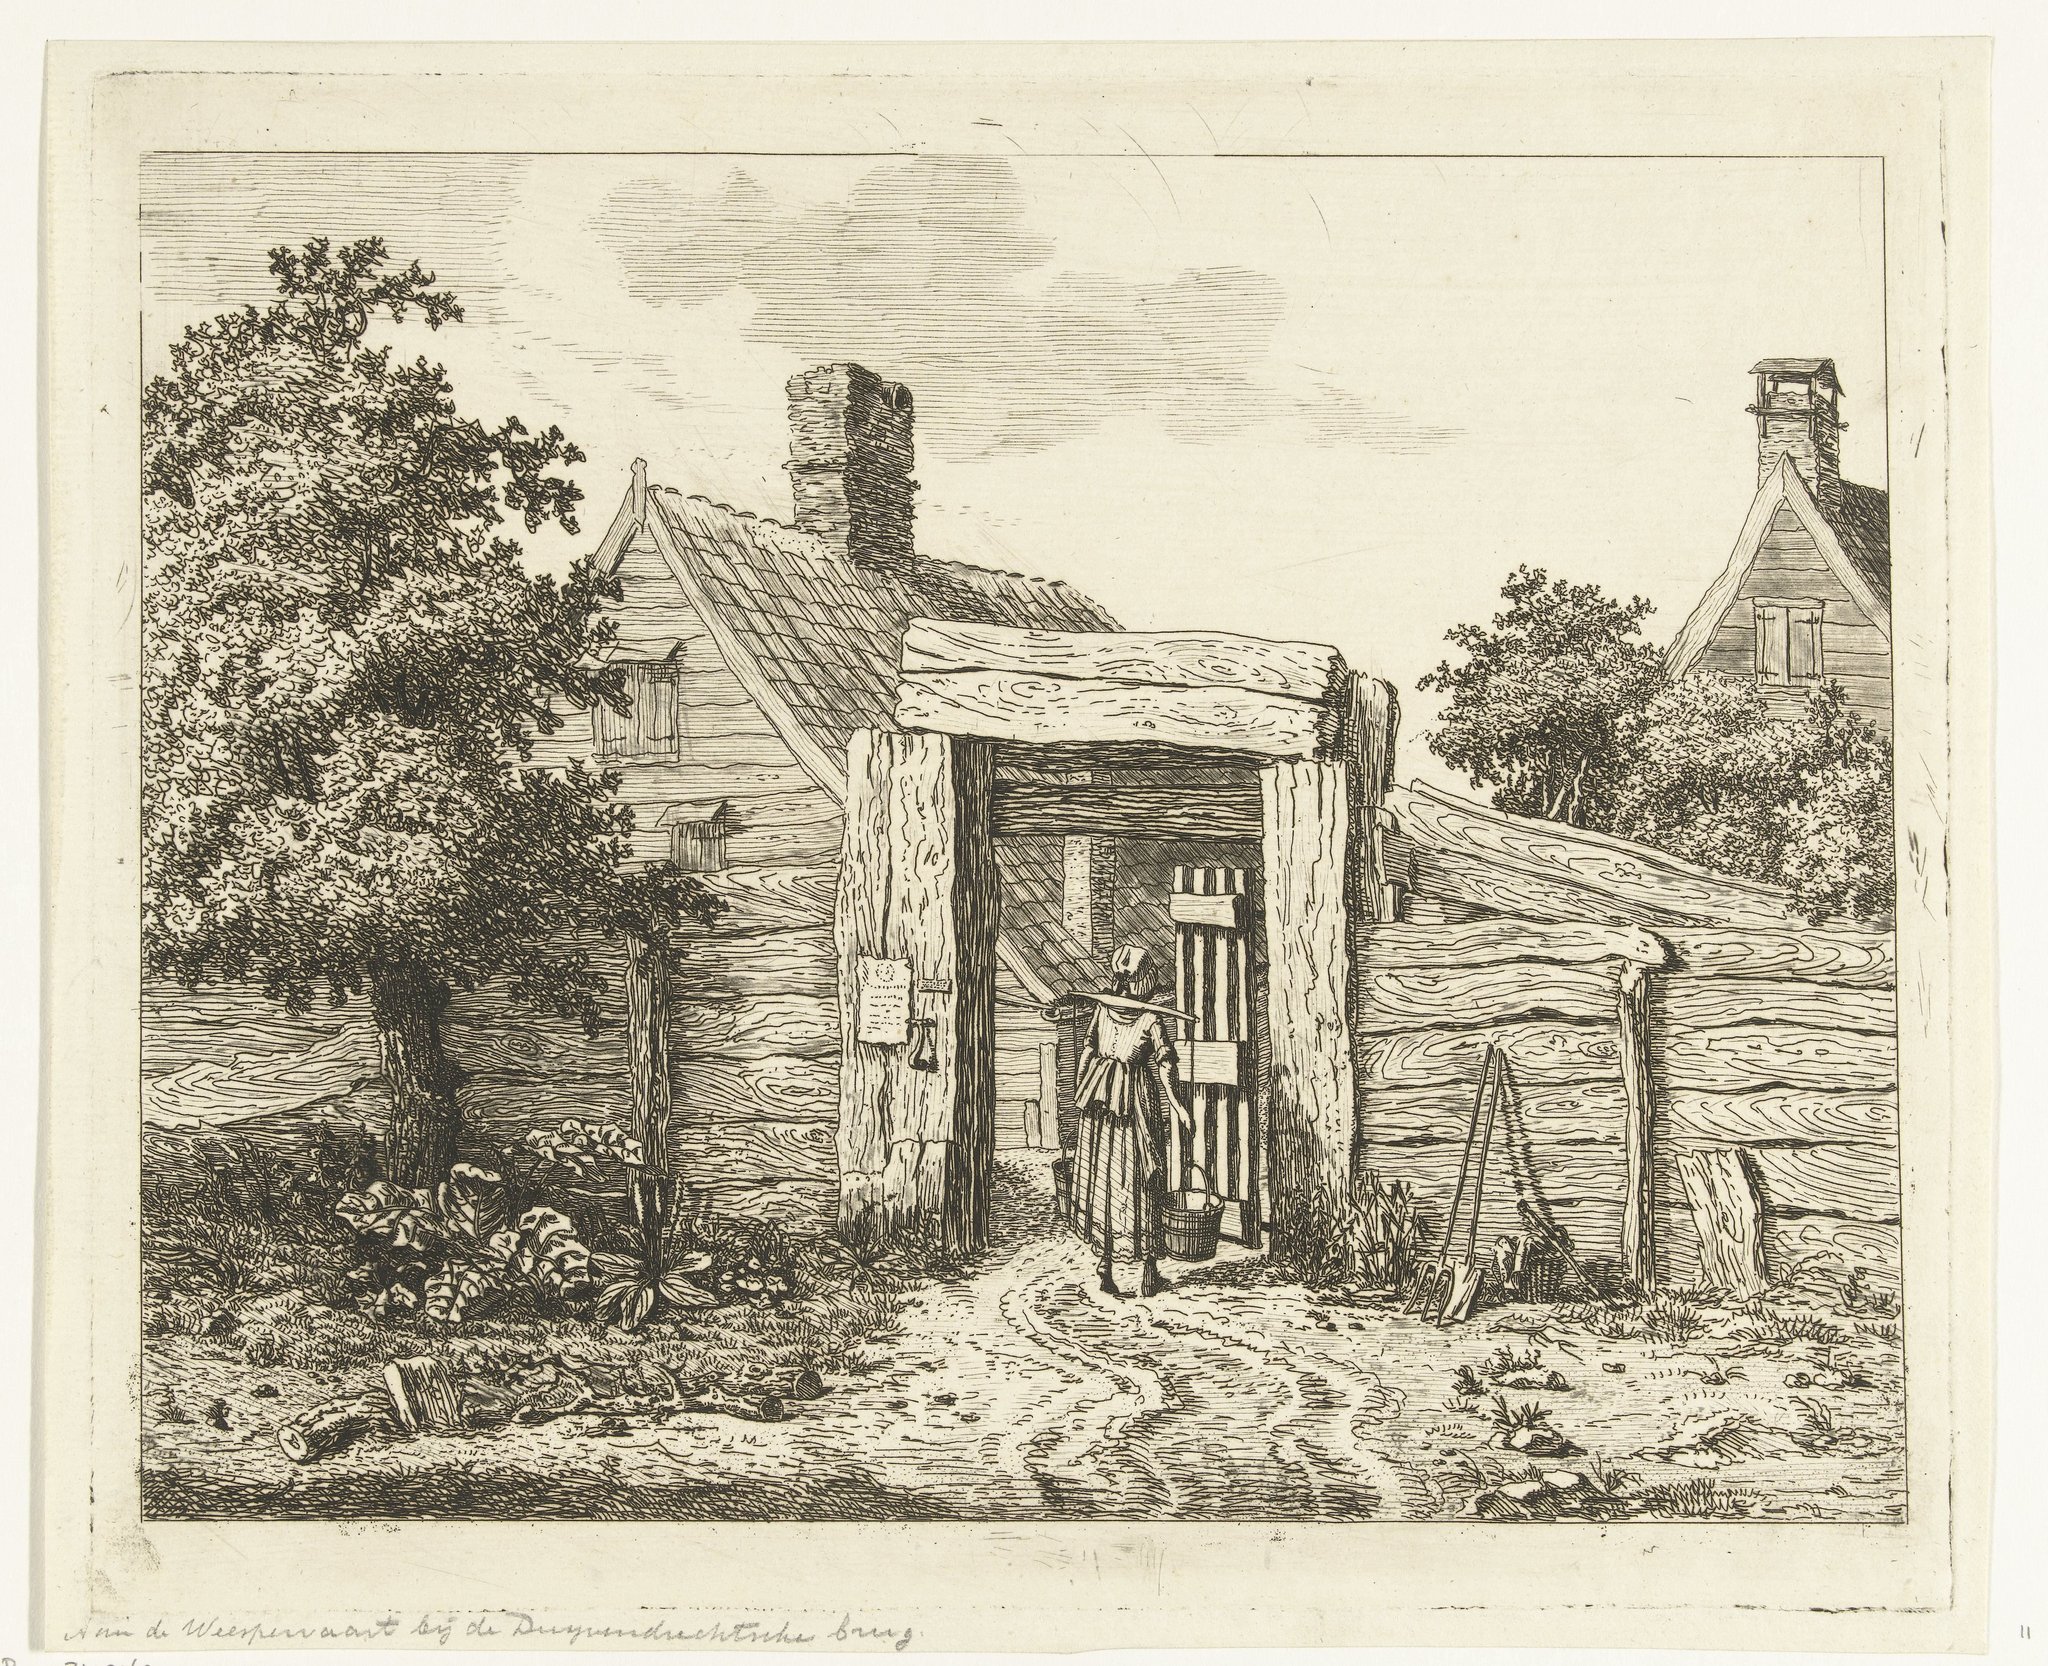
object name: print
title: Melkmeisje bij de poort van een boerderij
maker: anthonie van den bos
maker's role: draughtsman, print maker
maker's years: 1763-1838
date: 1778-1838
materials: paper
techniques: drypoint, etching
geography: netherlands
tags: milking (+ transport of products ~ crafts, industries, agriculture)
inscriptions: collector's mark: Lugt 2228